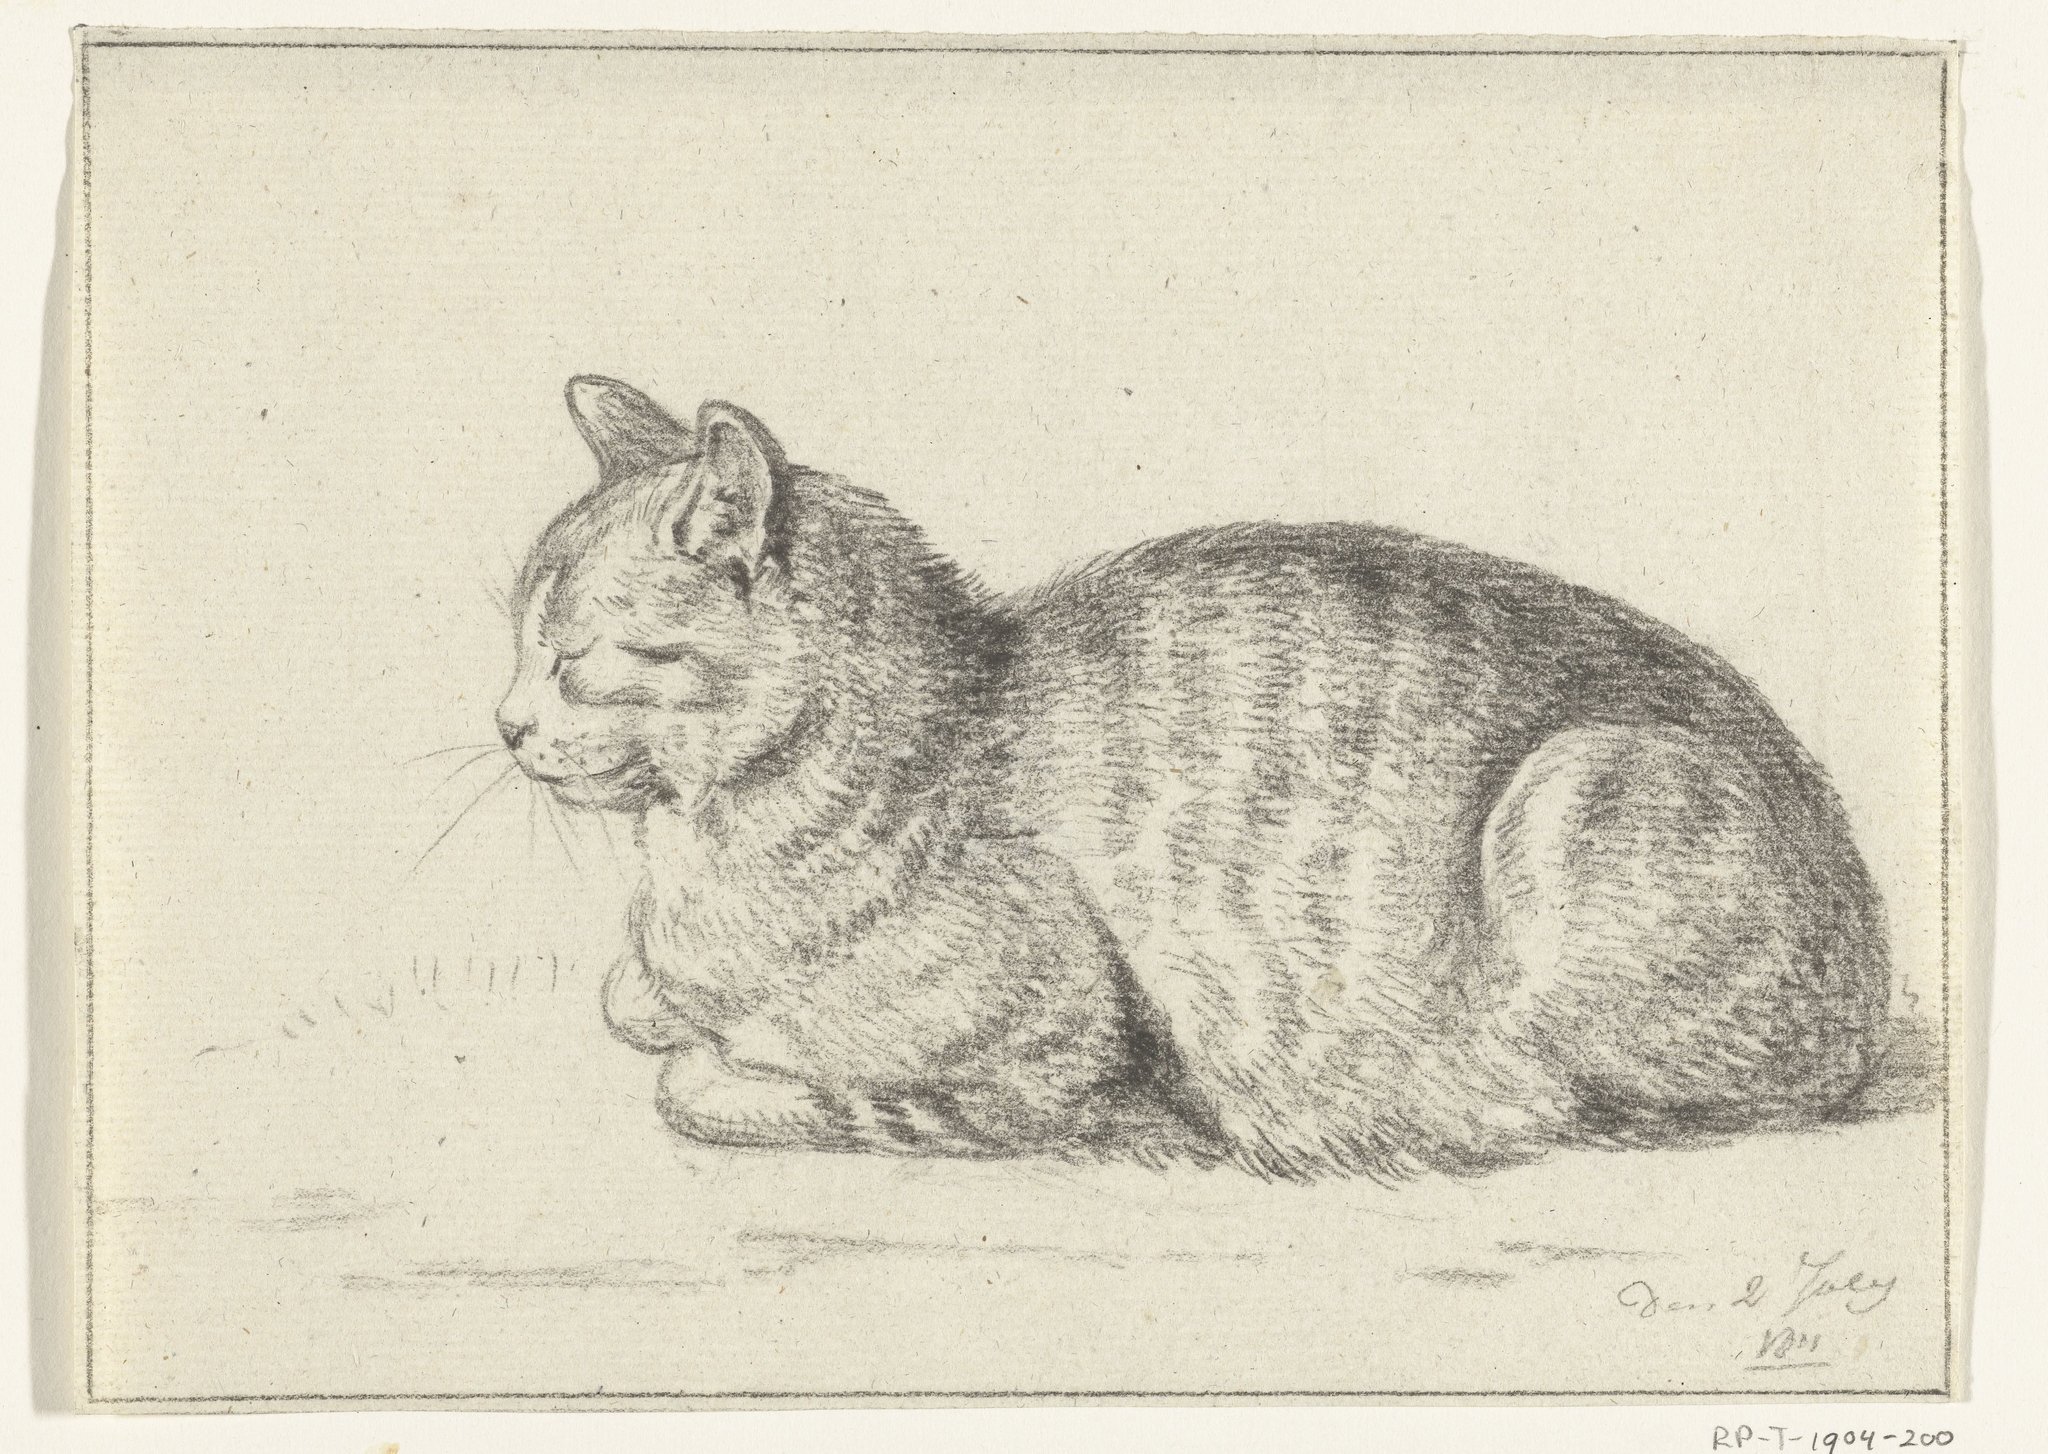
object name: drawing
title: Liggende kat, naar links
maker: jean bernard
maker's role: draughtsman, print maker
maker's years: 1765-1833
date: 1811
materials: chalk, paper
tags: cat